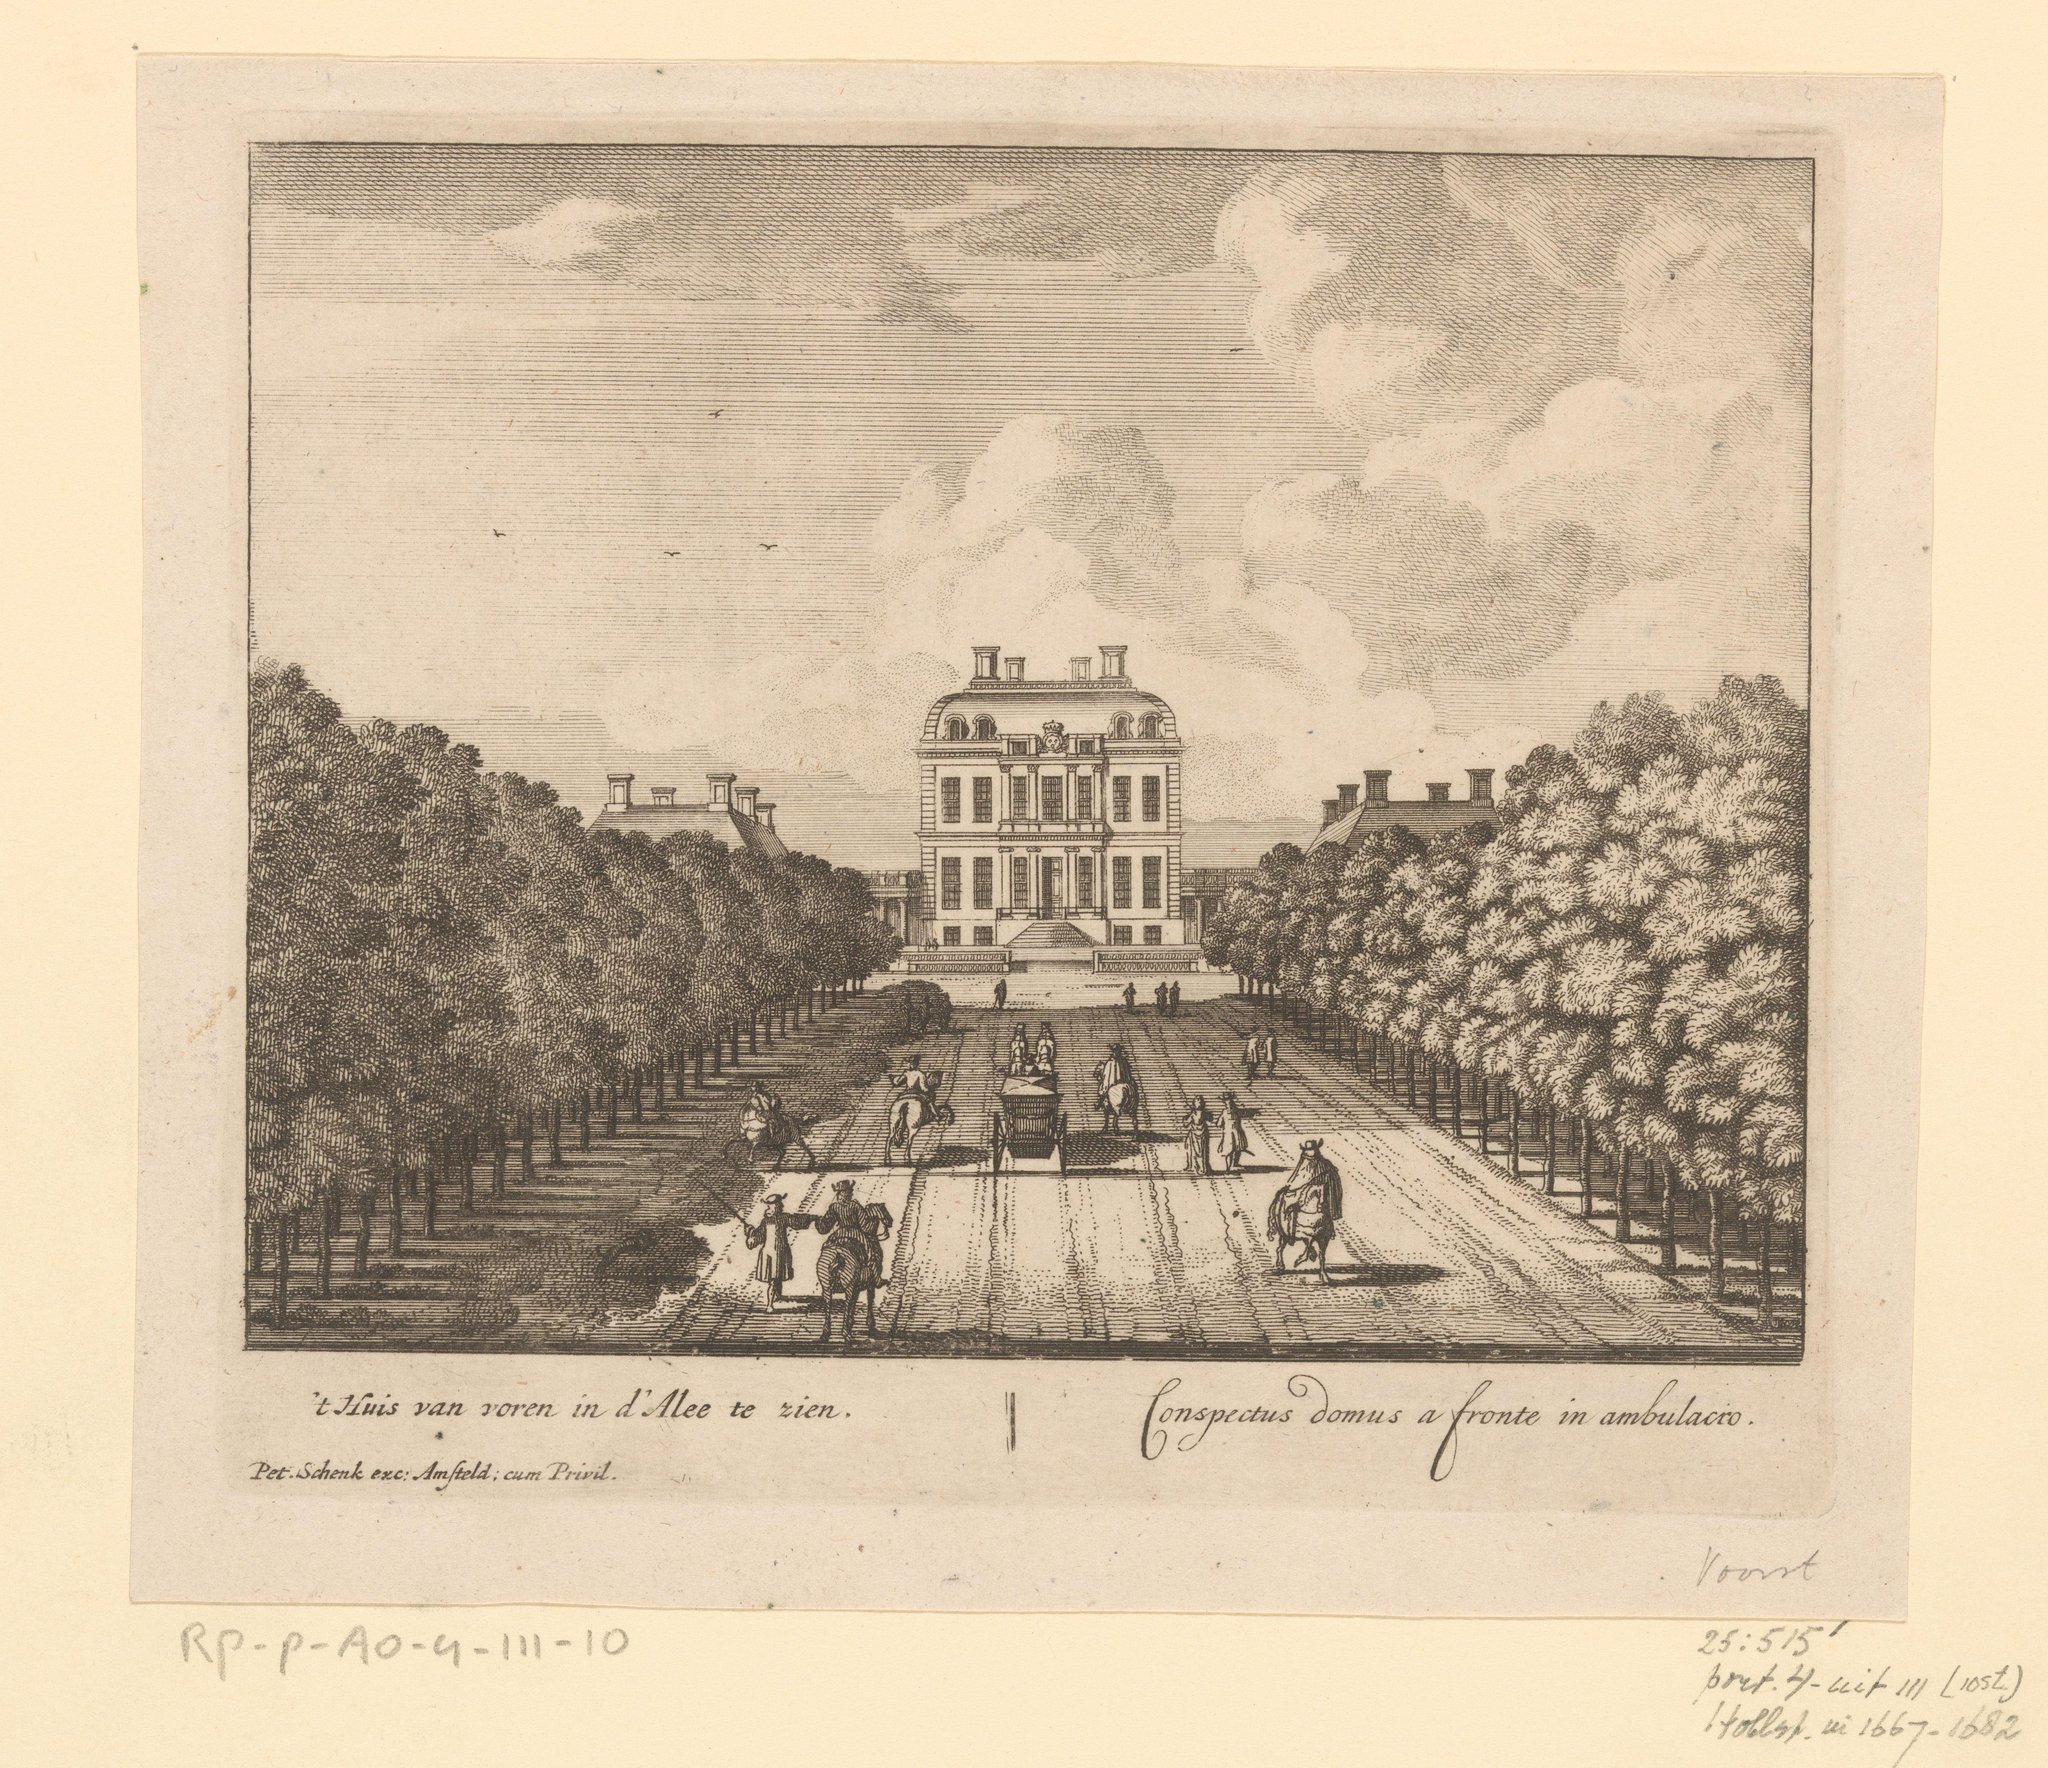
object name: print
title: Gezicht op Huis de Voorst gezien vanaf de oprijlaan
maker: pieter schenk (i)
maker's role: print maker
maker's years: 1660-1711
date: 1700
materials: paper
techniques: engraving, etching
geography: amsterdam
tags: palace, french or architectonic garden; formal garden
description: Prent is uitgeven door Pieter Schenk (I) als onderdeel van de zestiendelige prentserie 'Praetorium Dieranum', ca. 1700. Later is de prent ook gebruikt in: Schenk, Pieter (I). Paradisus Oculorum: sive conspectus degantissimi centum (...). Jacobus Romanus, ca. 1700.